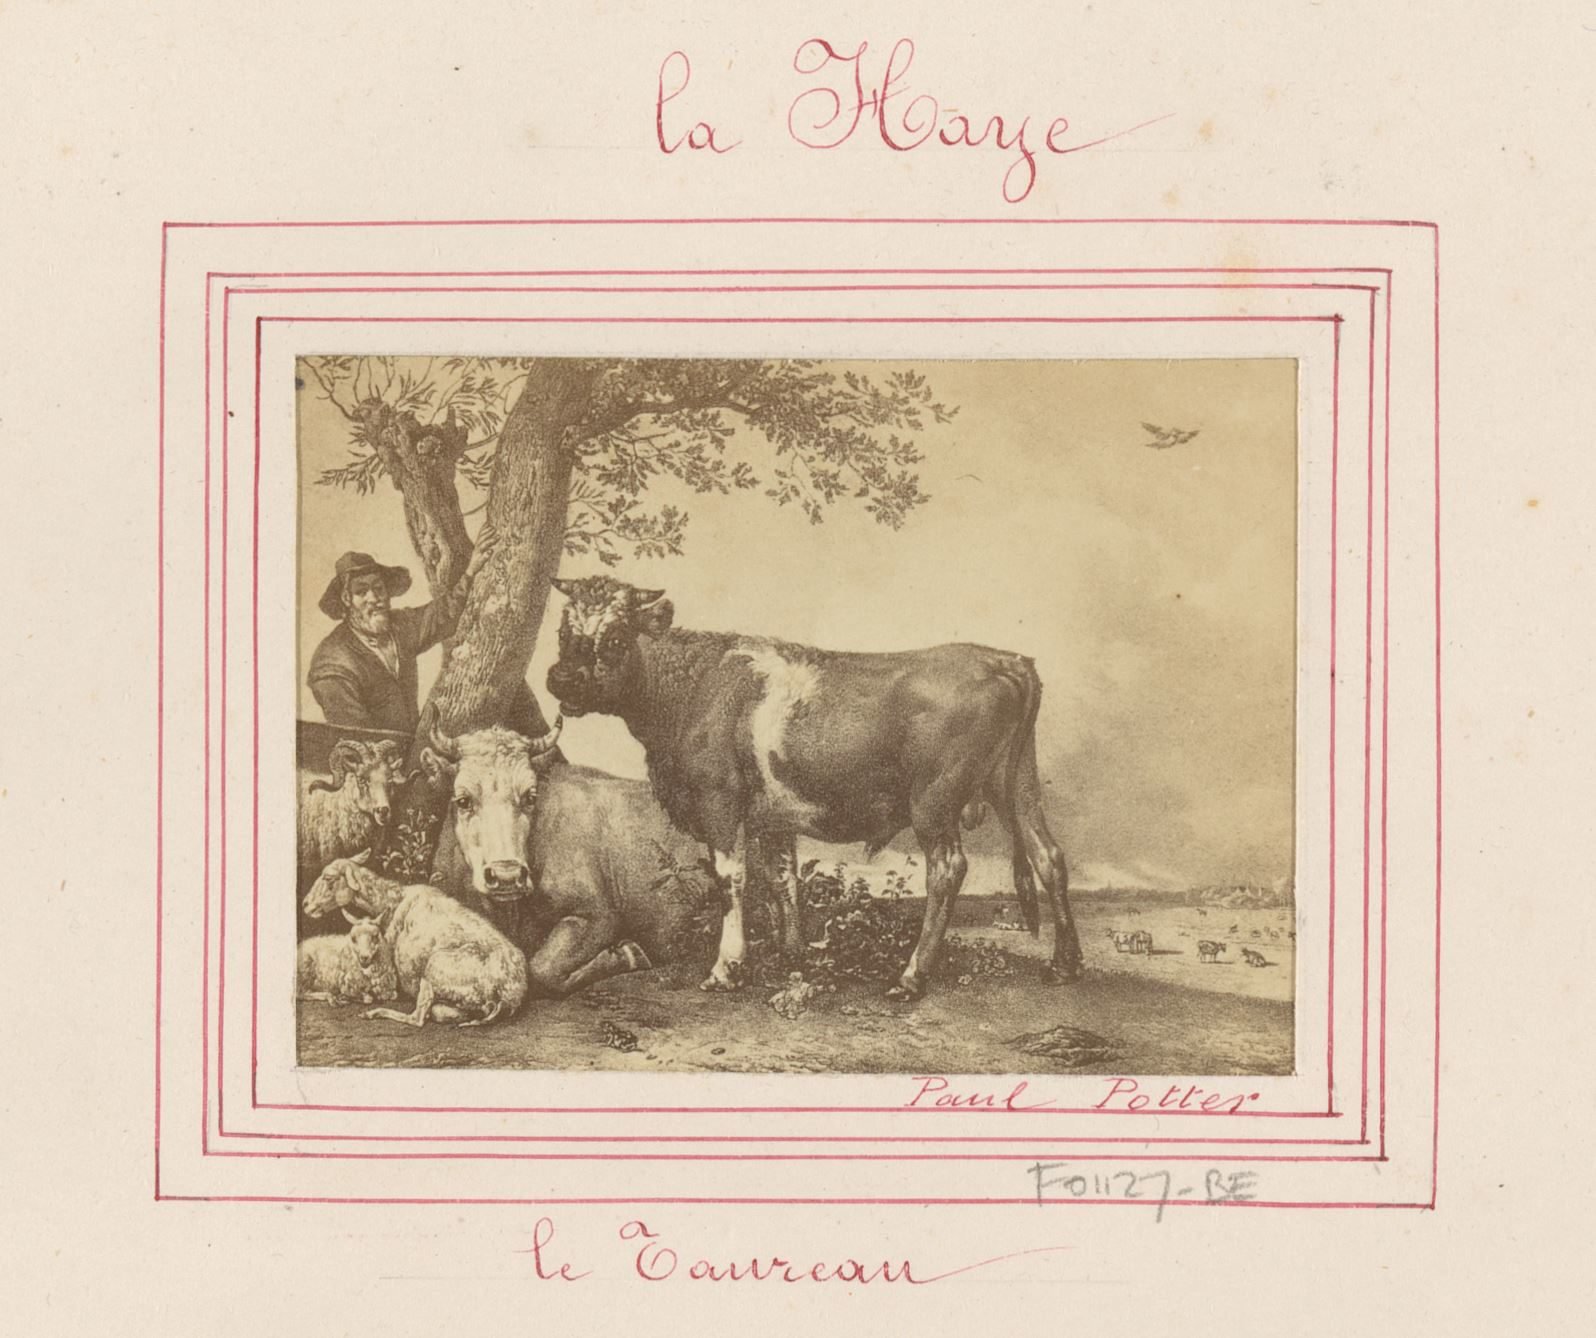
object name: reproduction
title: Fotoreproductie van een prent naar het schilderij De stier door Paulus Potter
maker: Anonymous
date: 1865-1875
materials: photographic support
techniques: albumen print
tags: bull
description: Onderdeel van Album met foto's en litho's van bezienswaardigheden in Noord- en Zuid-Hollandse steden, schilderijen en klederdrachten.